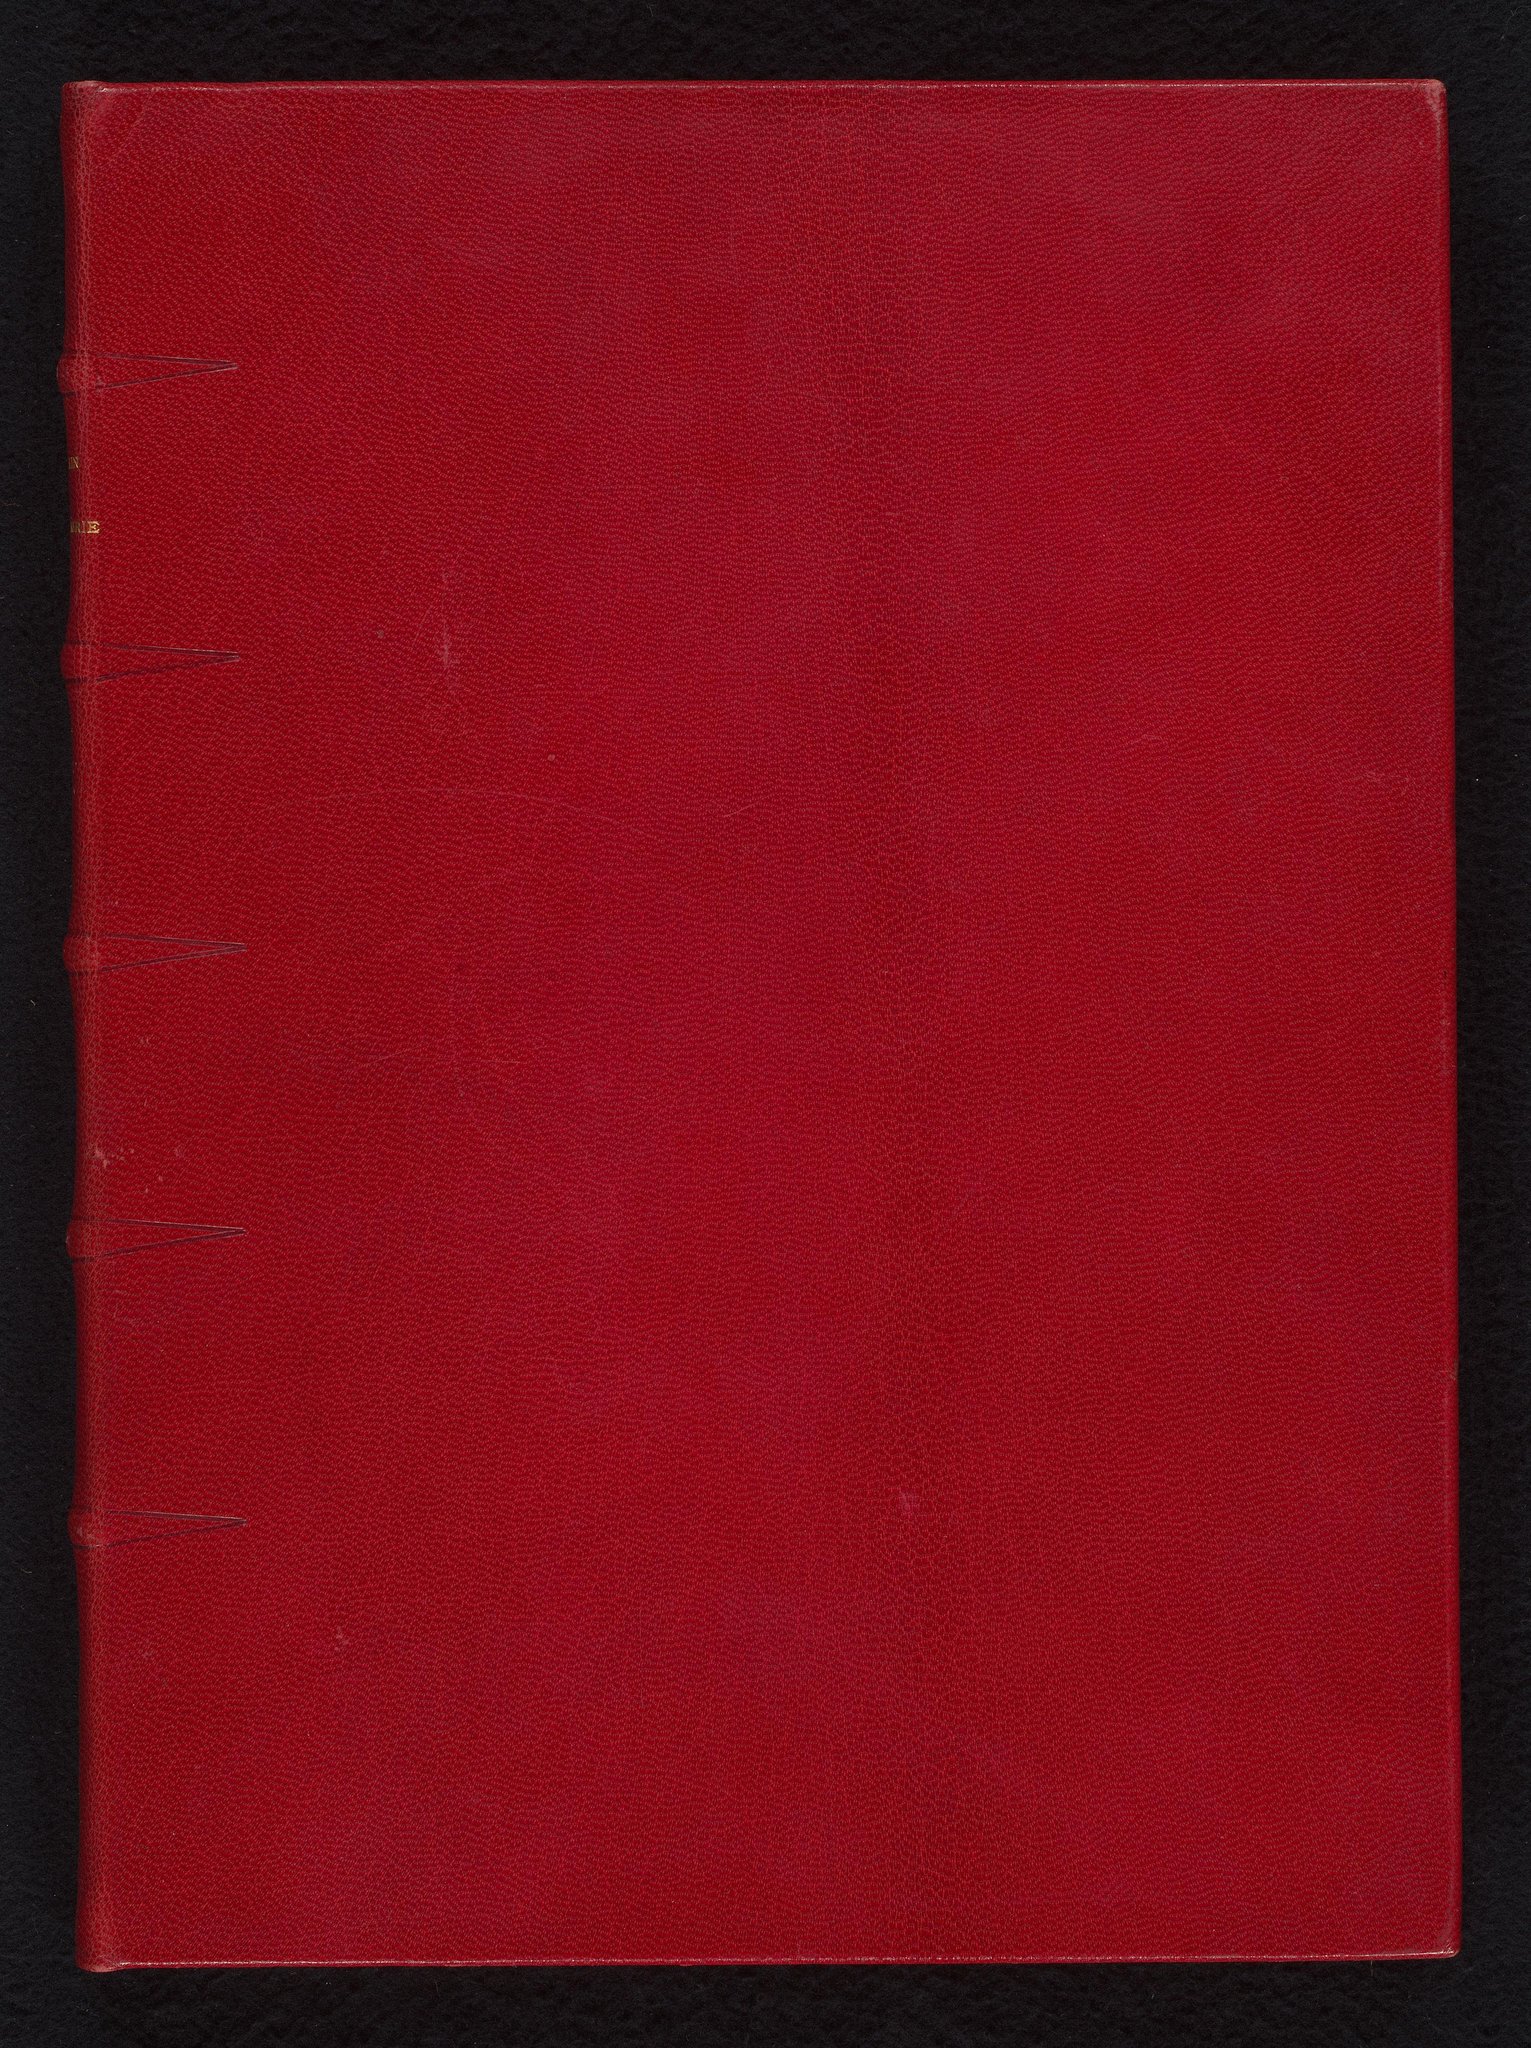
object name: prentrecueil, prentenalbum, prentalbum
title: Germain orfévrerie I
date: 1748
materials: leather, gold leaf, paper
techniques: bookbinding, printing, etching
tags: reading, jeweller, goldsmith, silversmith, work of applied art (+ precious metals ~ arts)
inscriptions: collector's mark: ‘Rijks Musm B’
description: Germain, Pierre. Elements d'orfevrerie divisés en deux parties de cinquante feuilles chacune composéz par Pierre German marchand orfevre Joaillieu a Paris. 2 dln. Parijs: Weduwe François Chereau [?], 1748, deel 1. De (ongesigneerde) band om beide delen stamt waarschijnlijk uit het eerste kwart van de twintigste eeuw.